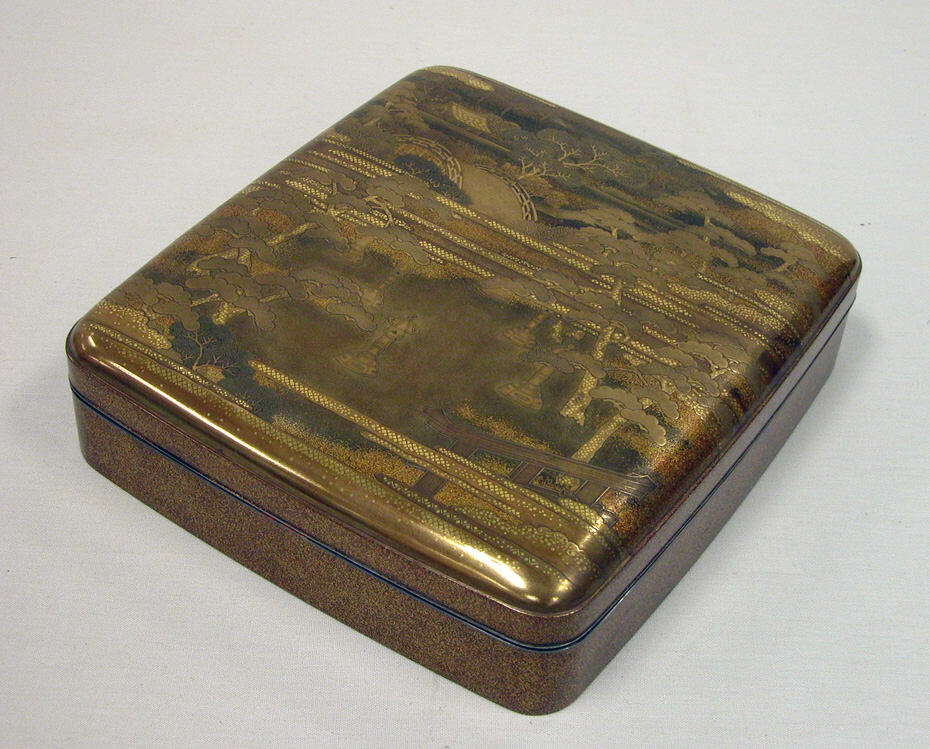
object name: writing box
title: Writing Box with Design of the Sumiyoshi Shrine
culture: japanese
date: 1801-1900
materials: gold, lacquer, silver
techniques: maki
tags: landscapes